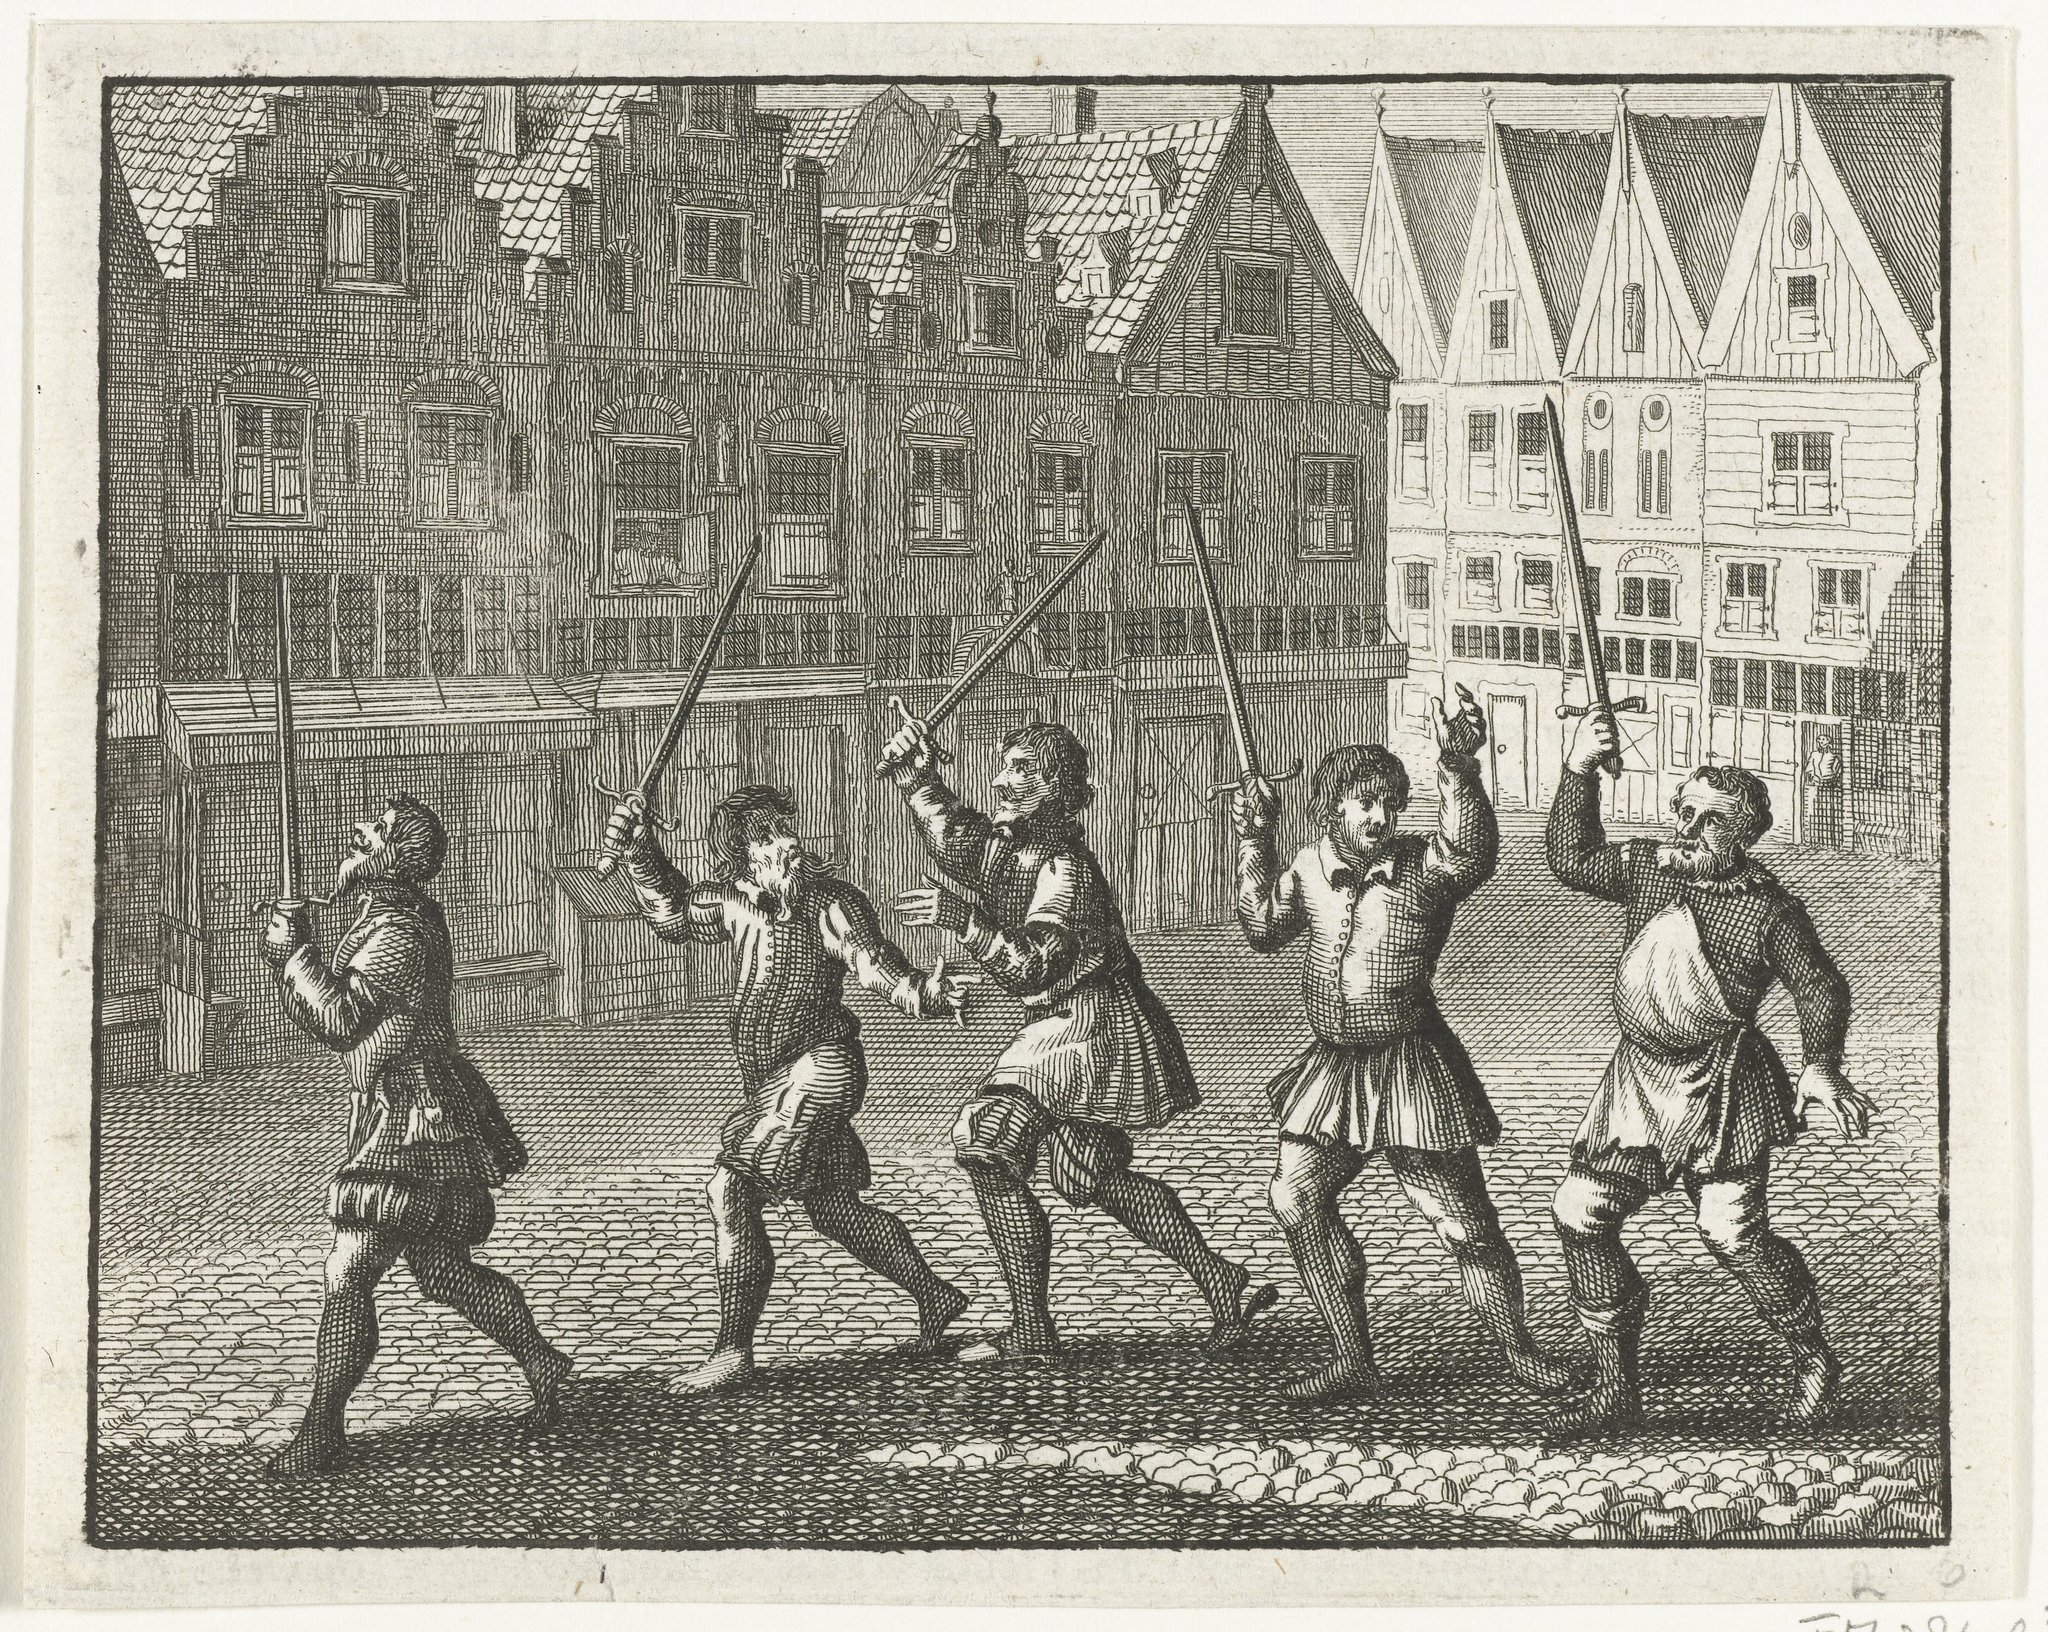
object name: print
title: Zwaardlopers te Amsterdam, 1534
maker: Anonymous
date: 1650-1699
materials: paper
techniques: engraving, etching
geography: northern netherlands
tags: amsterdam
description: Illustratie voor een onbekend werk. Deze prenten zijn gebaseerd op de anonieme gravures in de eerste uitgave Hortensius' Van den oproer der weder-dooperen uit 1614. Naar het verloren gegane schilderij van Barend Dircksz. in het oude stadhuis te Amsterdam.